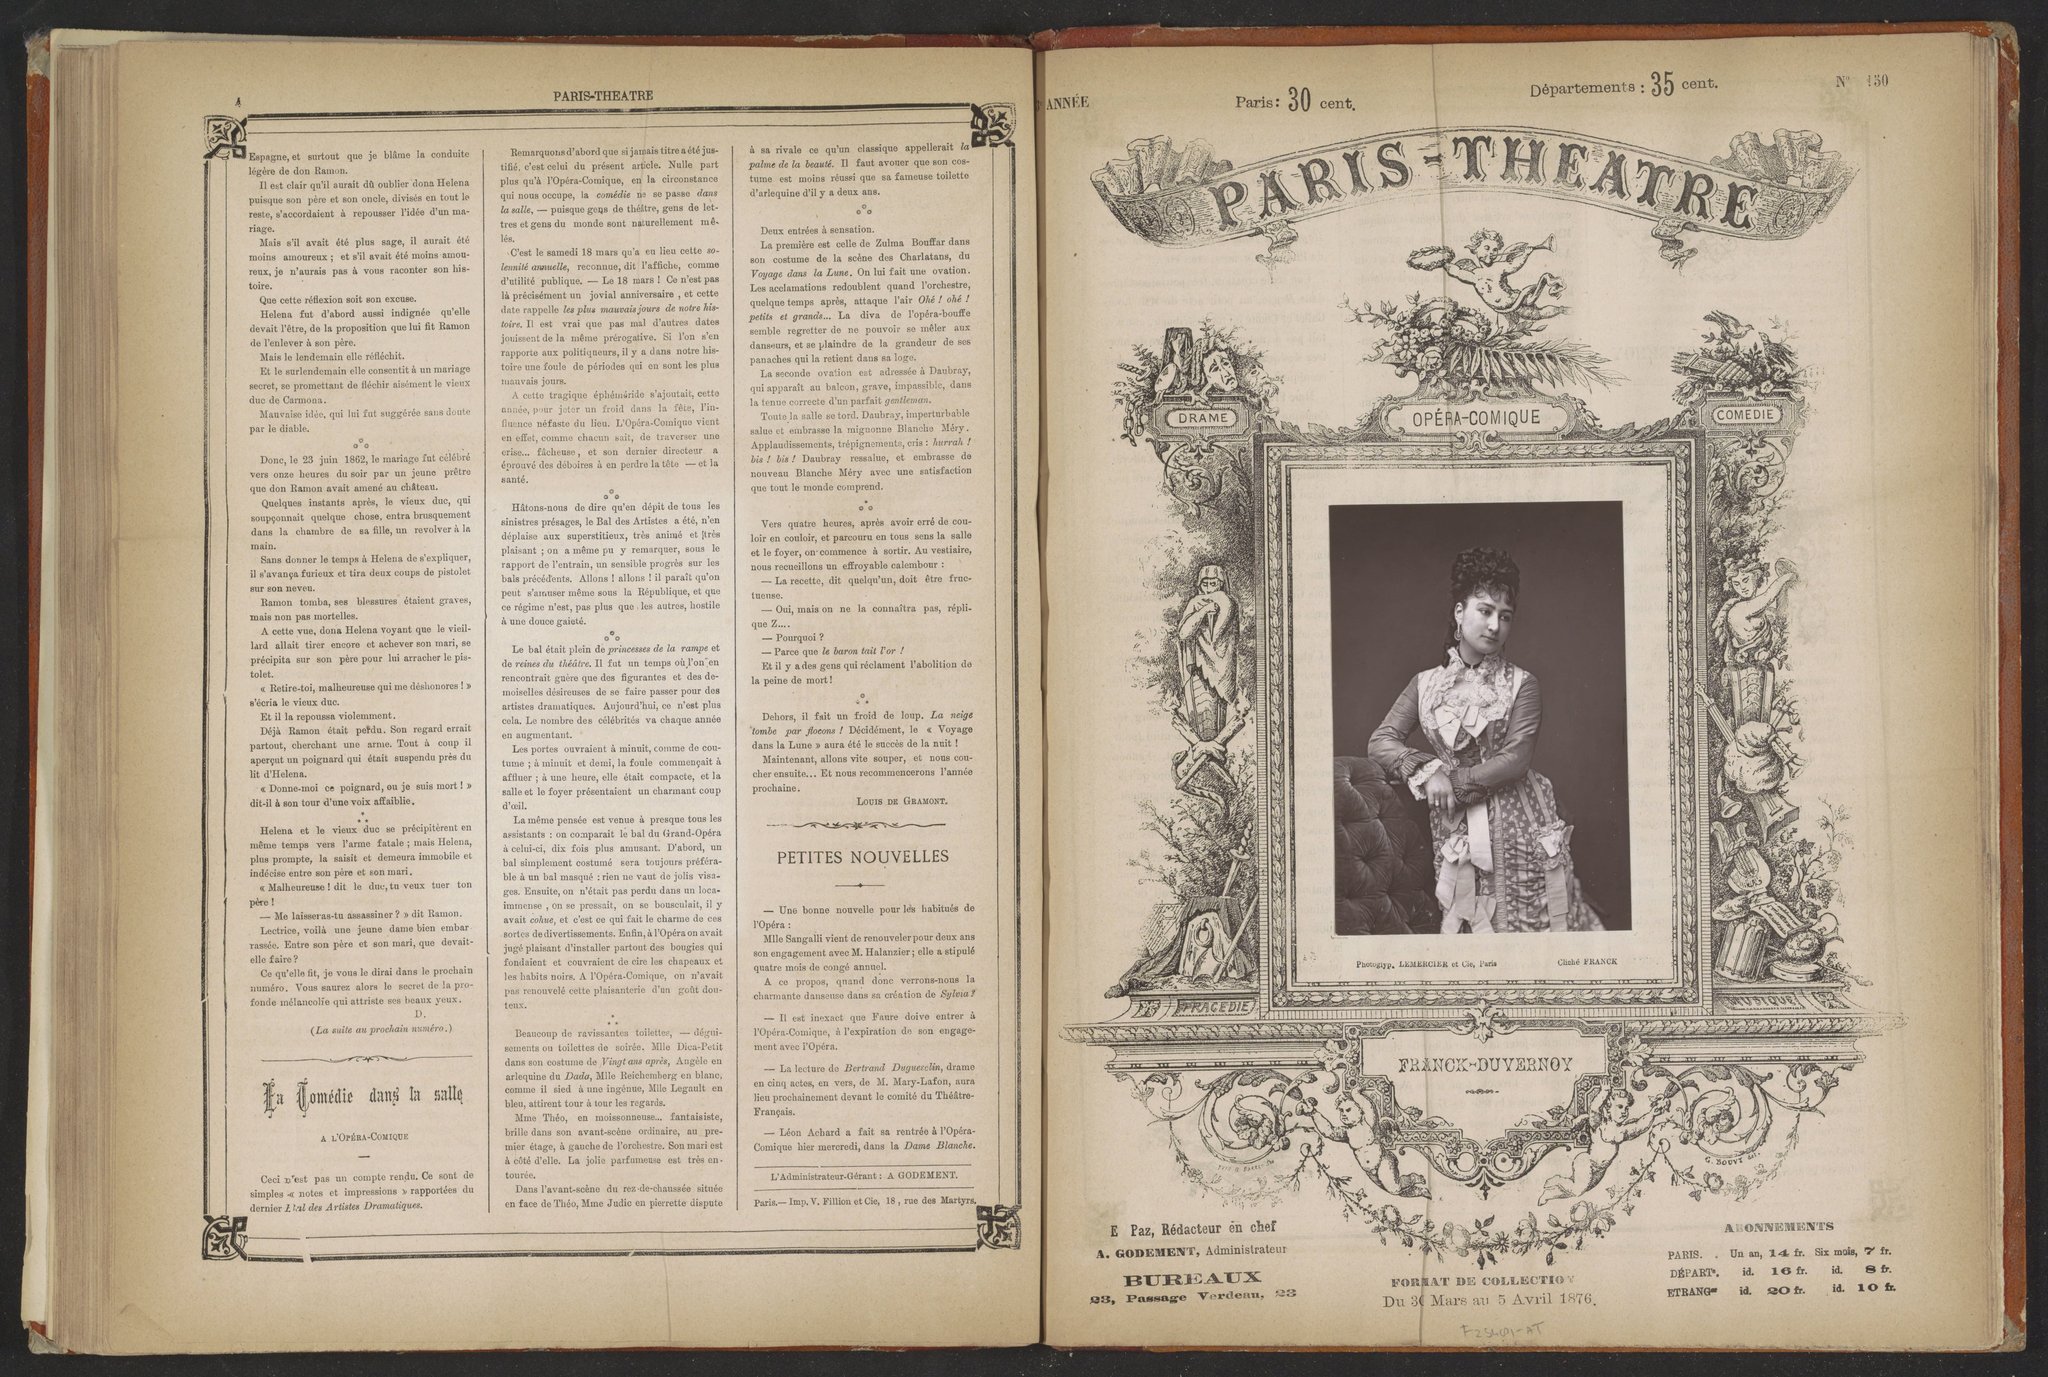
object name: page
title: Franck-Duvernoy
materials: paper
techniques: woodburytype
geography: paris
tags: zangeres, adèle franck-duvernoy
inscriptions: number: ‘No 150’, inscription: ‘Du 30 mars au 5 Avril 1876.’